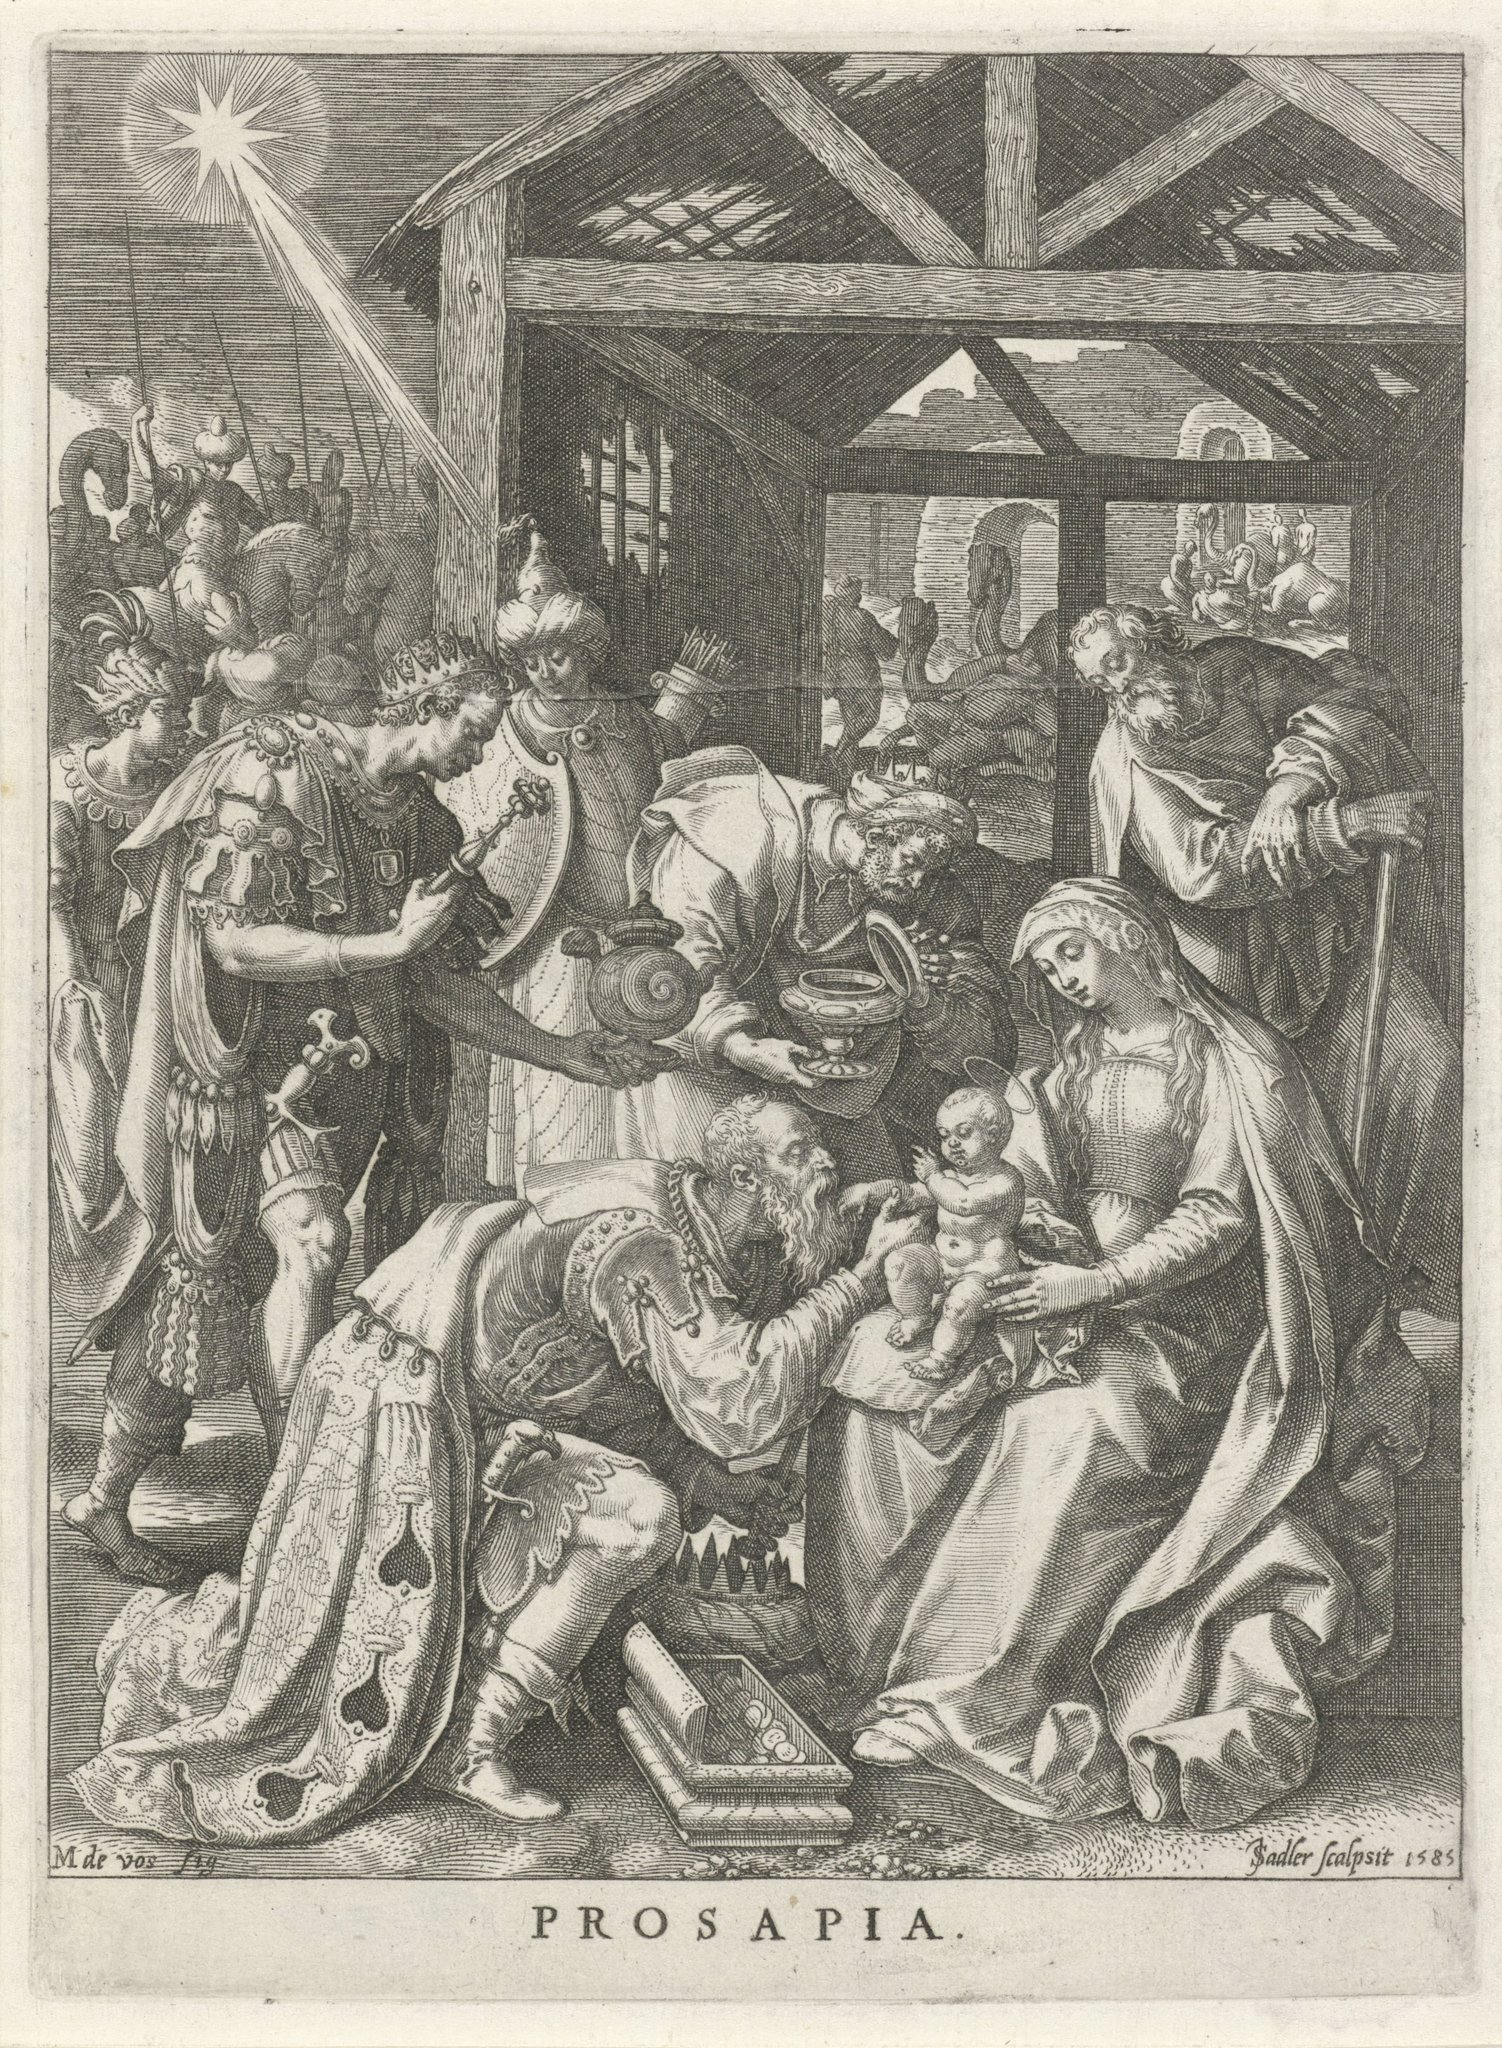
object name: print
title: Prosapia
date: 1585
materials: paper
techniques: engraving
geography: cologne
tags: adoration of the kings: the wise men present their gifts to the christ-child (gold, frankincense and myrrh), family life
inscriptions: collector's mark: Lugt 240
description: De drie koningen hebben een ster gevolgd tot aan de stal. Ze groeten het Christuskind en bieden geschenken aan. De tweede prent van een achtdelige serie met scènes uit het leven van Christus die zijn belangrijkste deugden verbeelden.